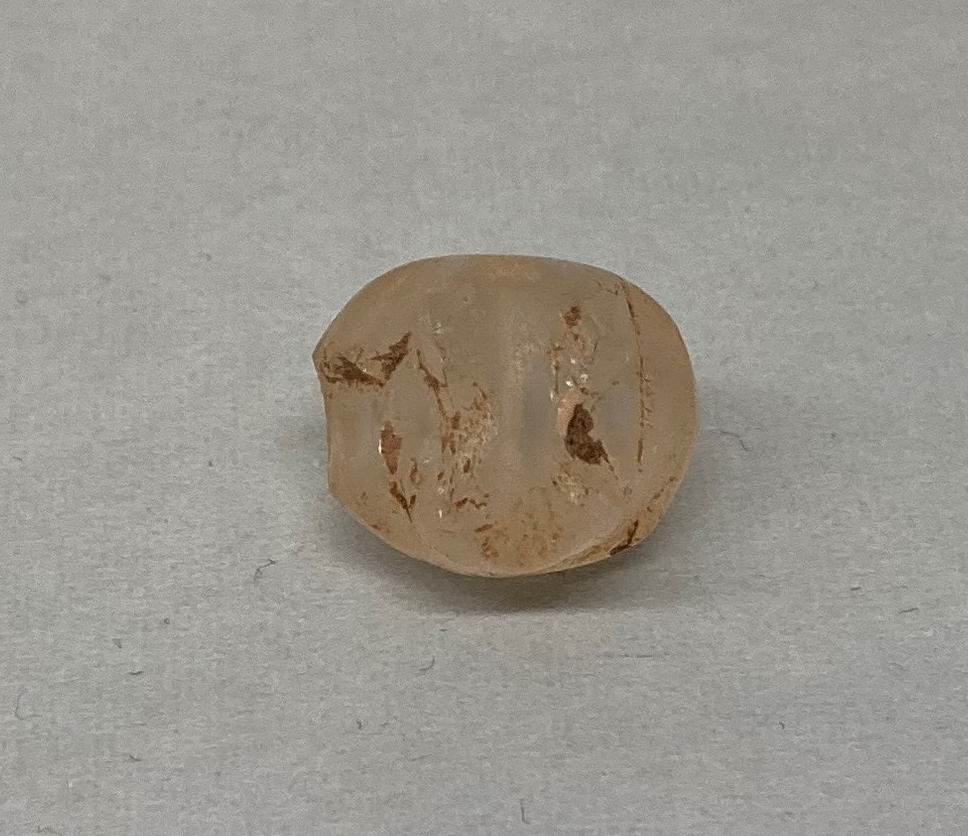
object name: bead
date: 801-1200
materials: glass, quartz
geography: iran